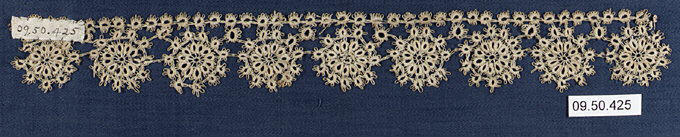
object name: edging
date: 1801-1900